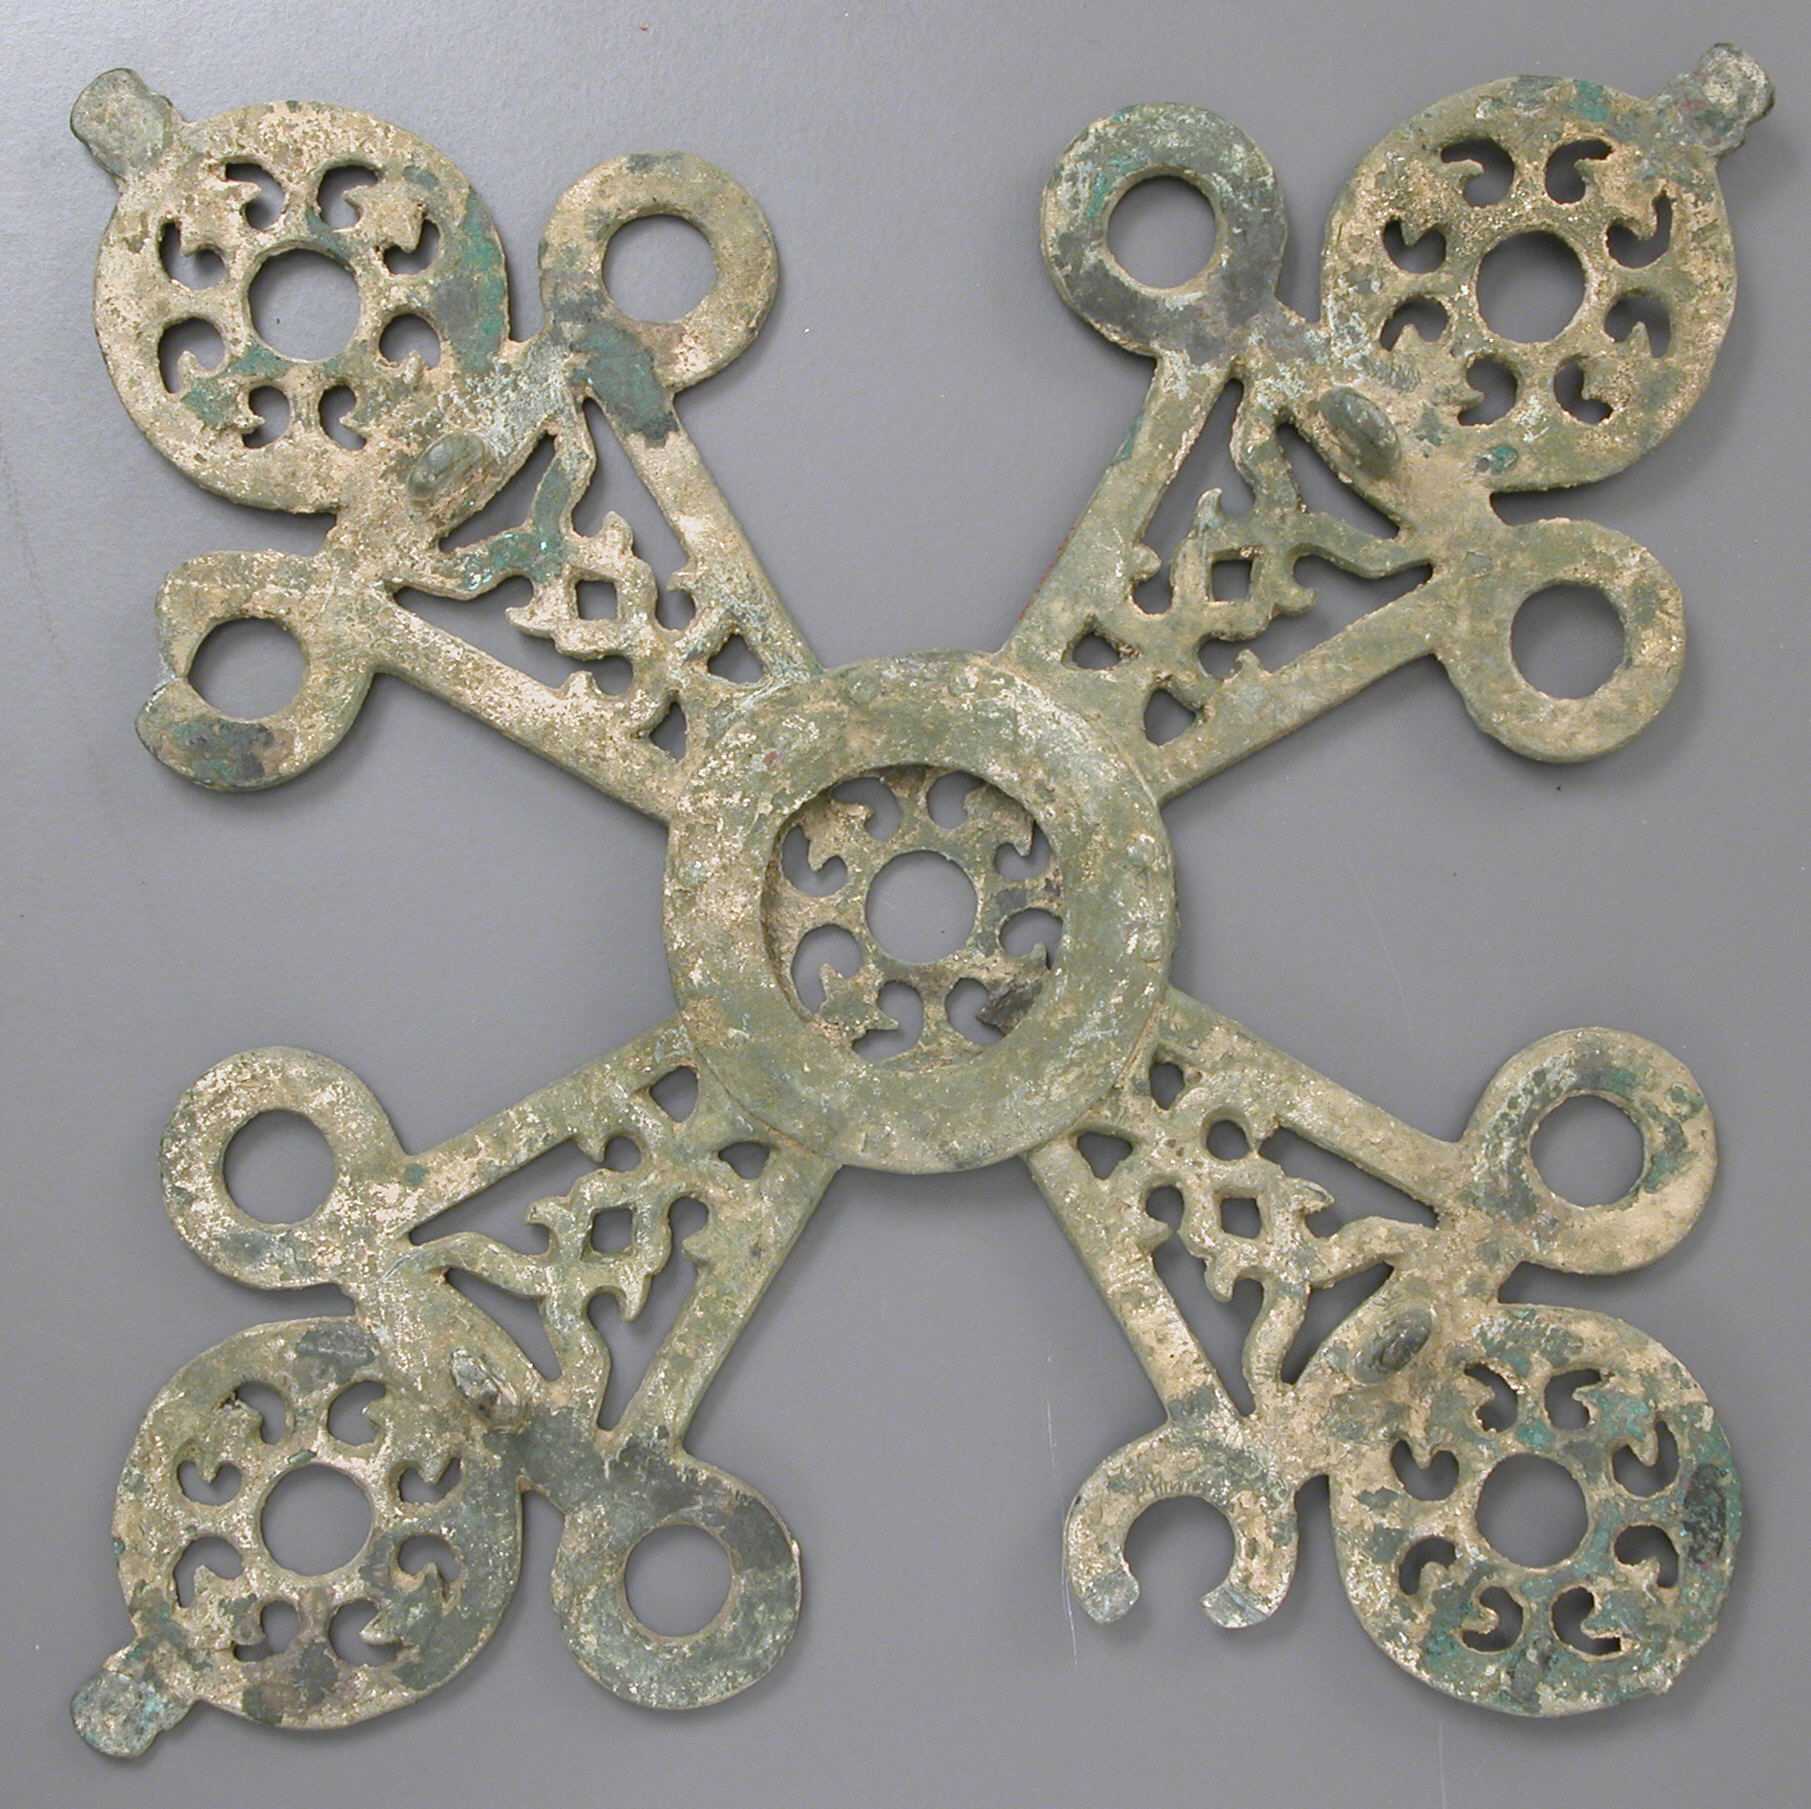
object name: polycandelon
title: Cross-Shaped Hanging Lamp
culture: byzantine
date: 1301-1400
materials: copper alloy